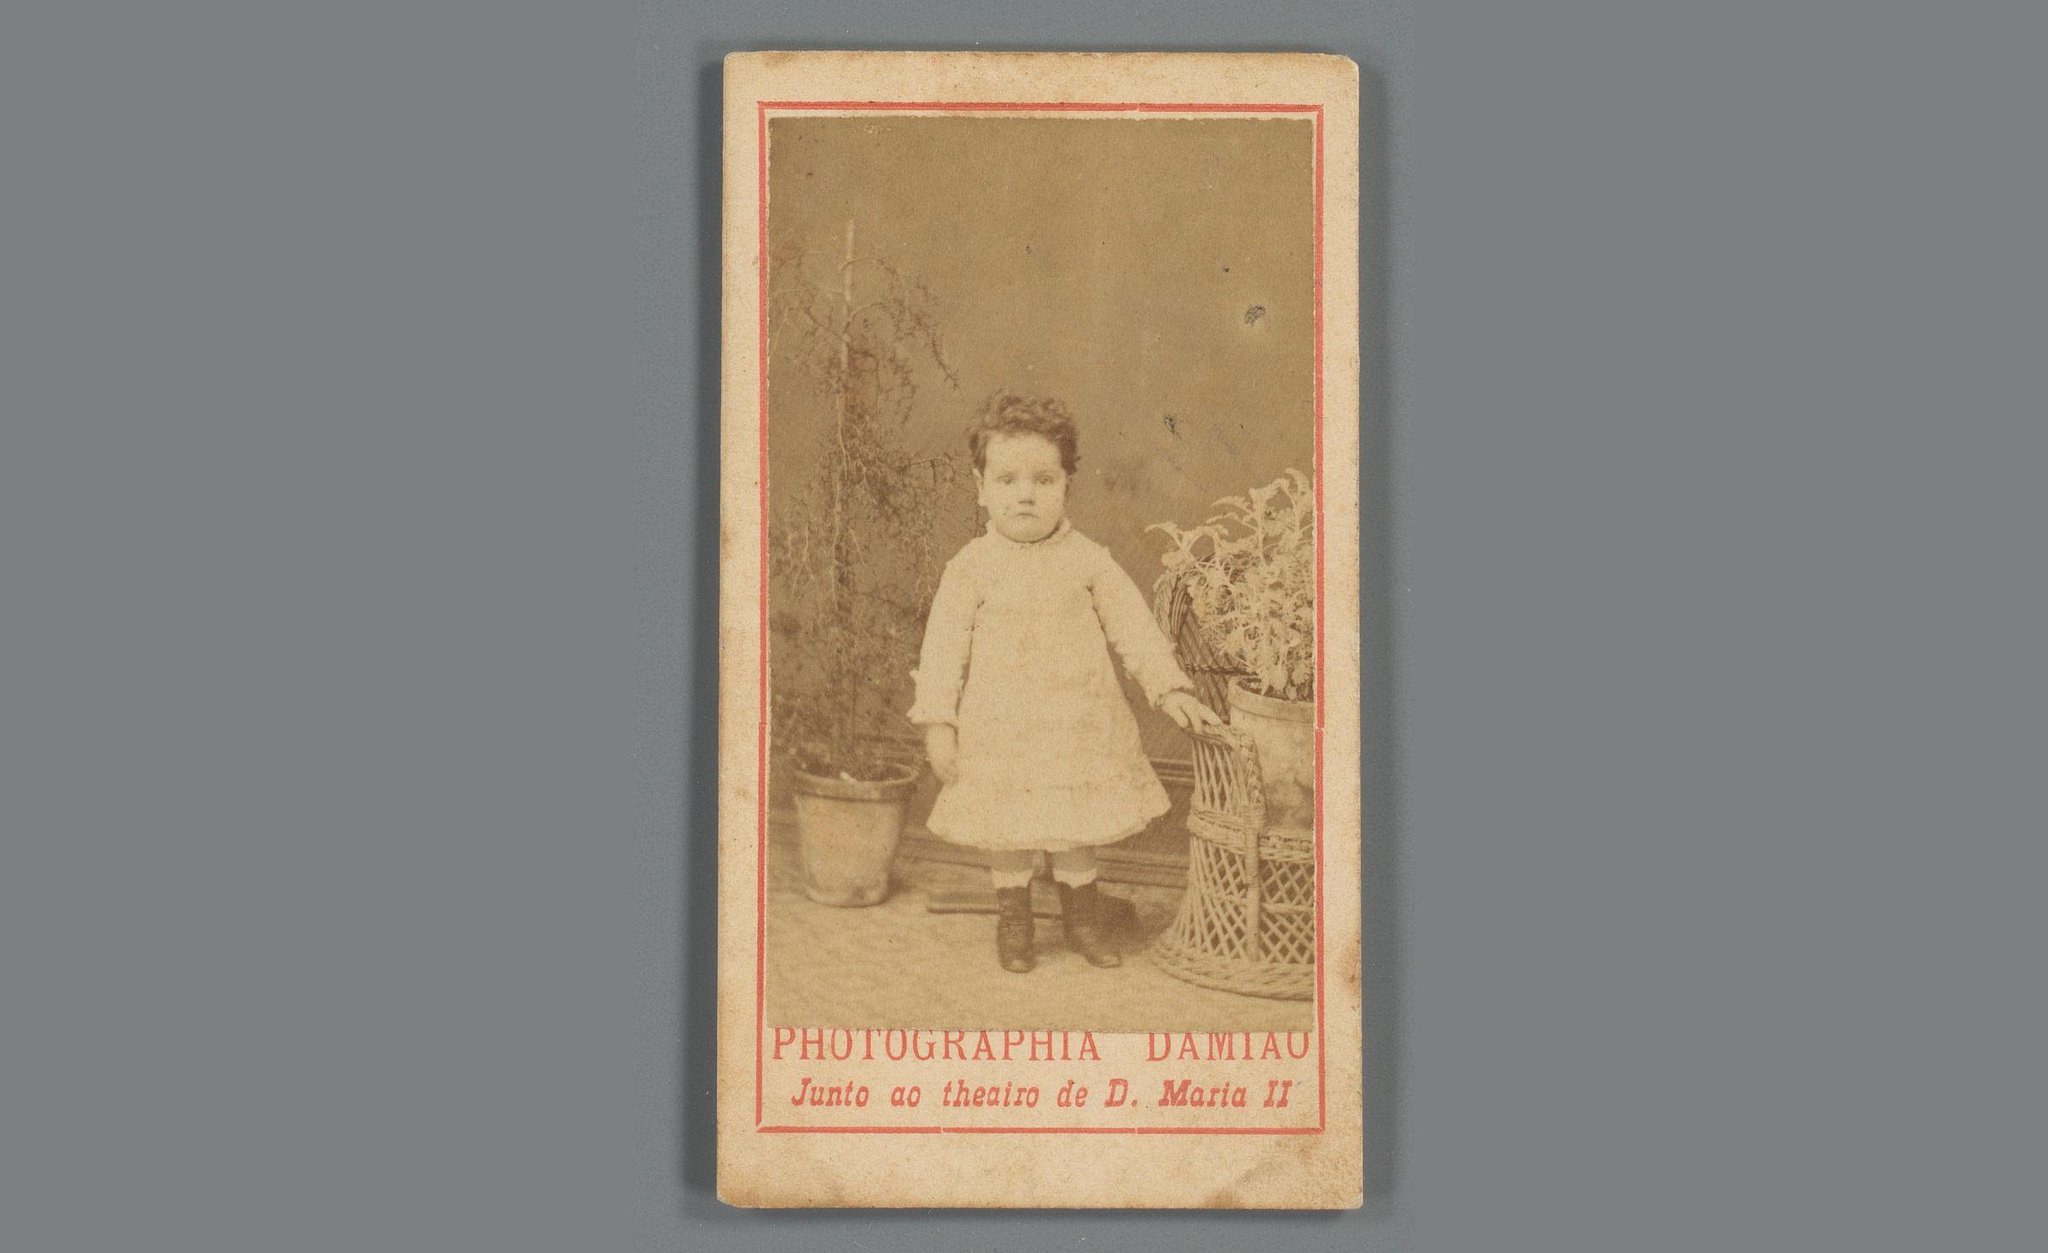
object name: photograph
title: Miniatuurportret van een onbekend meisje, genoemd Maria Amalia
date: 1879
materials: cardboard, paper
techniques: albumen print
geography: lisbon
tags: historical persons not known by name - bb - woman, girl (child between toddler and youth)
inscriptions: inscription: ‘Photographia Damiao/ Junto ao theairo de D. Maria II’, inscription: ‘Minha filha/ Maria Amalia/ 1879’